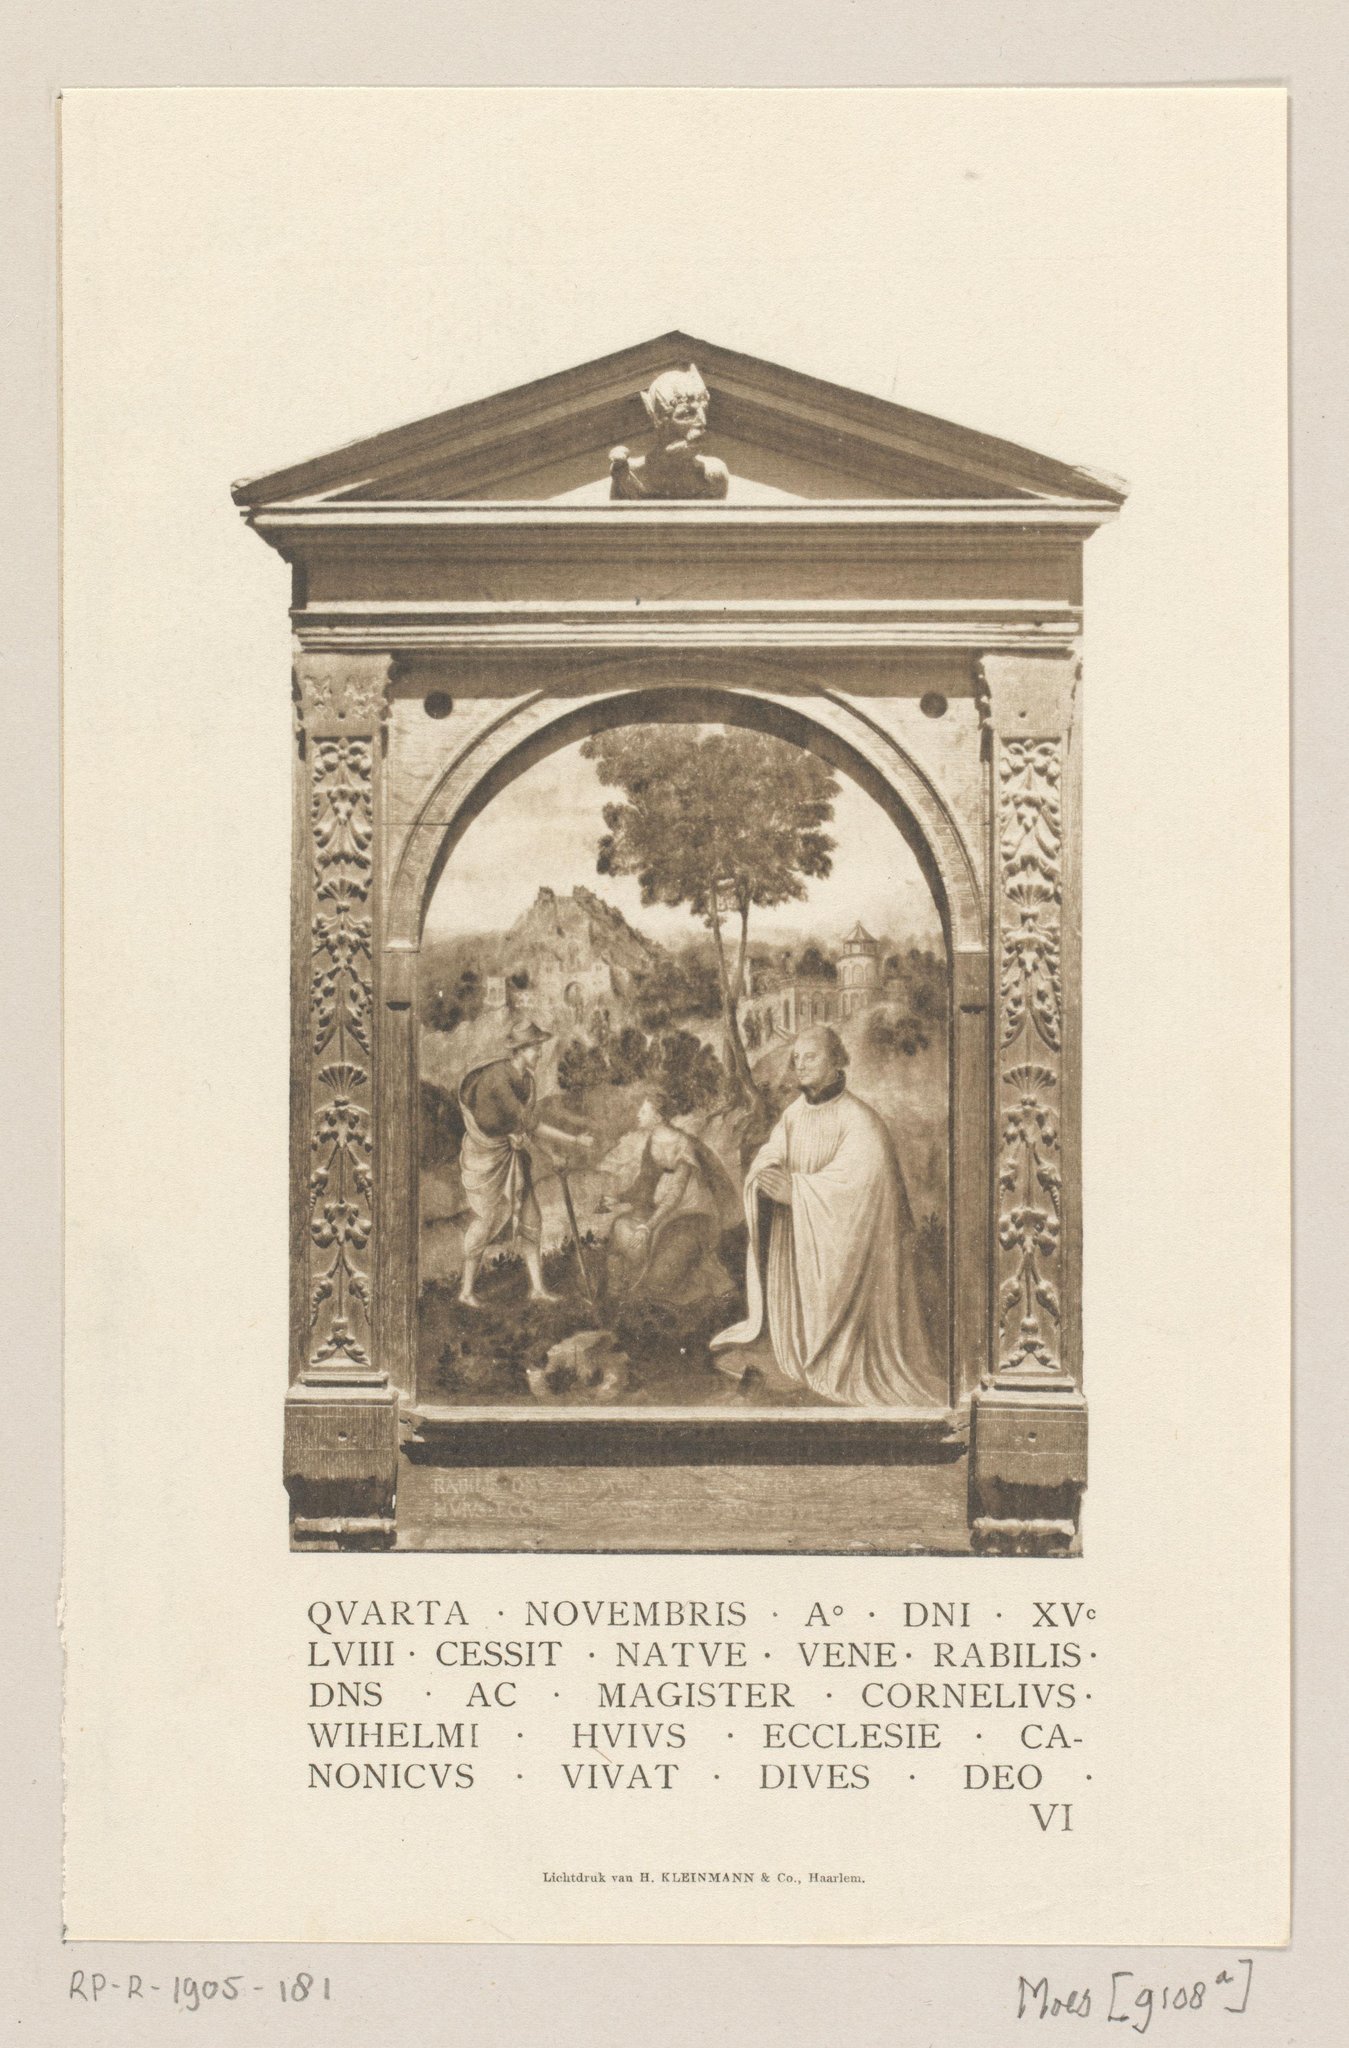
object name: reproduction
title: Reproductie van een schilderij ter ere van Cornelis Willemse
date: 1894-1906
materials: paper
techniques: photograph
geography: haarlem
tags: historical persons, picture, painting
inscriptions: collector's mark: Lugt 2228, inscription: ‘Leidsche school =/- 1550/ [...]’